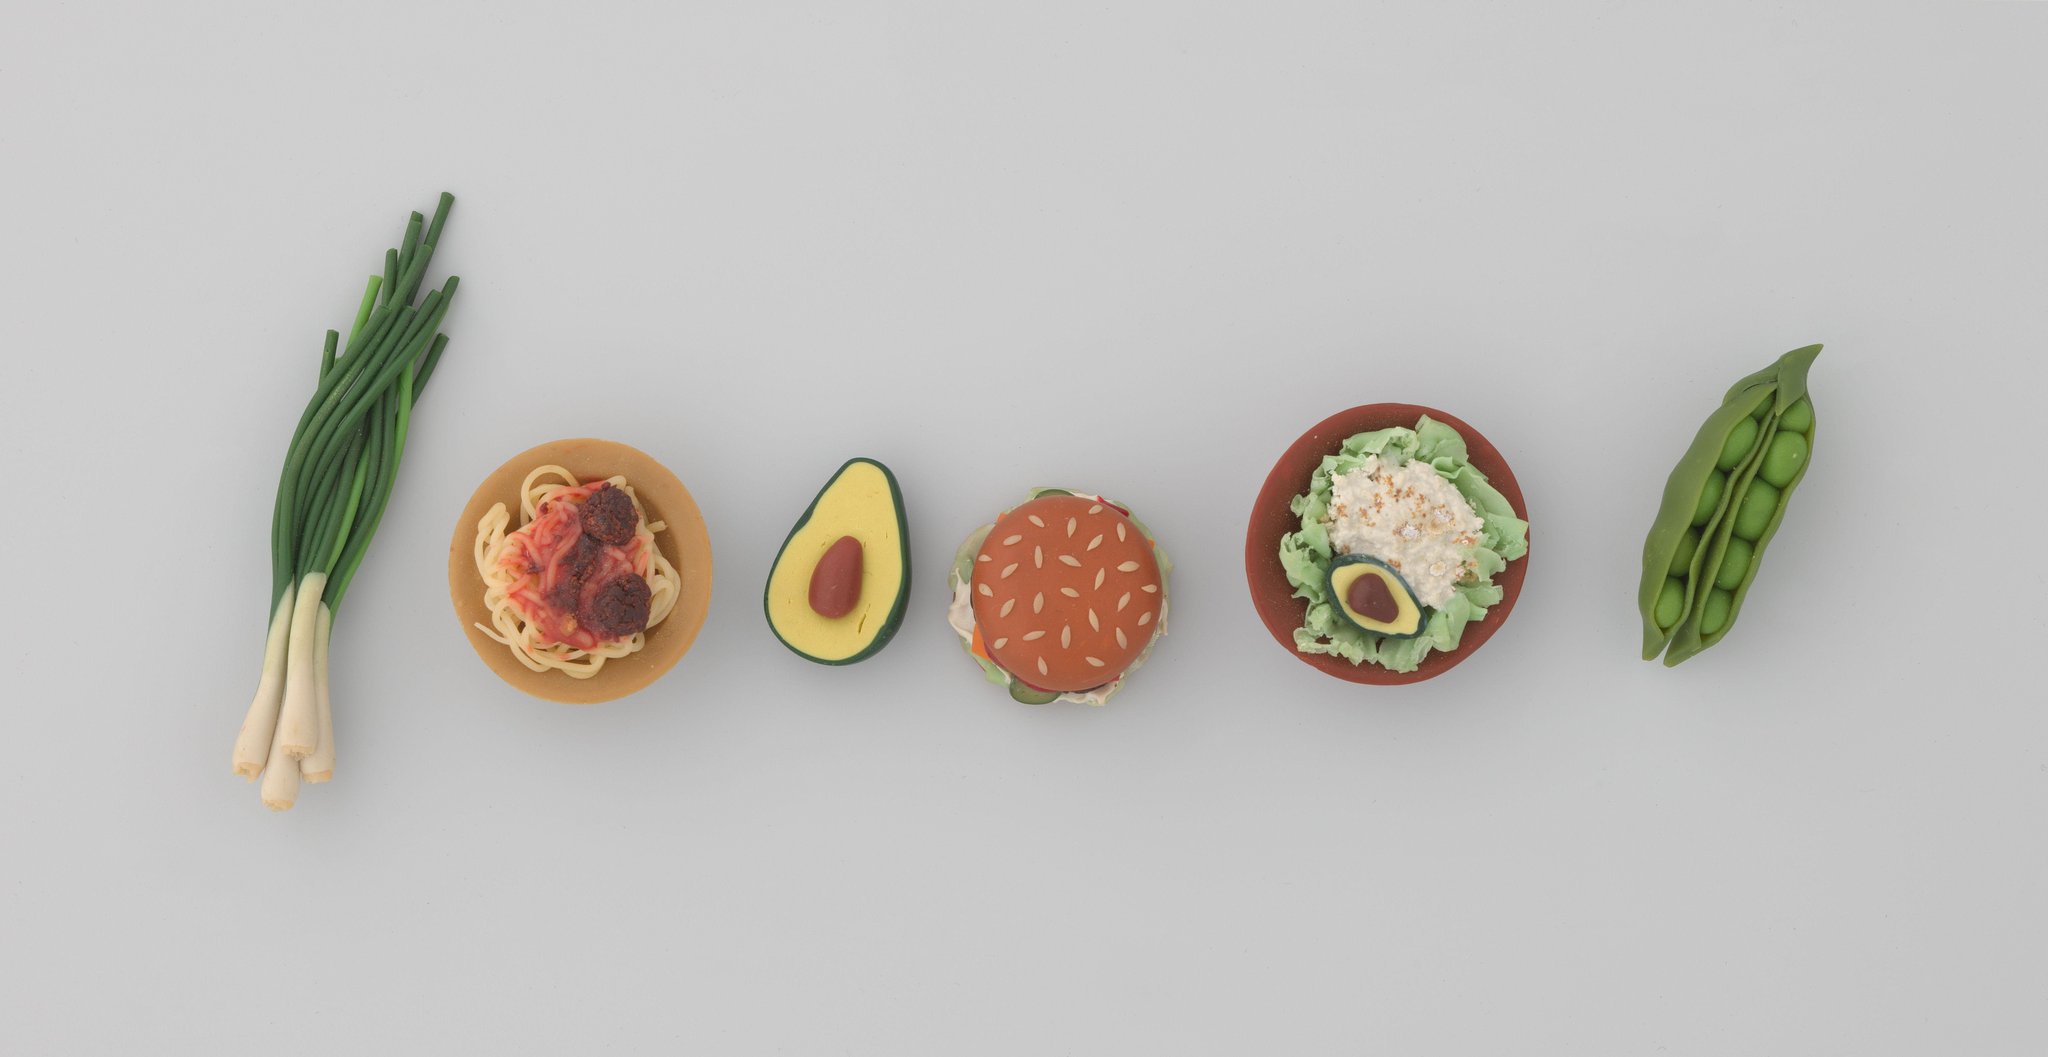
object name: brooch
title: Hamburger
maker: Anonymous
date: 1970-1980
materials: metal, plastic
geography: united states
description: De broche is voorzien van een stift met poucet.